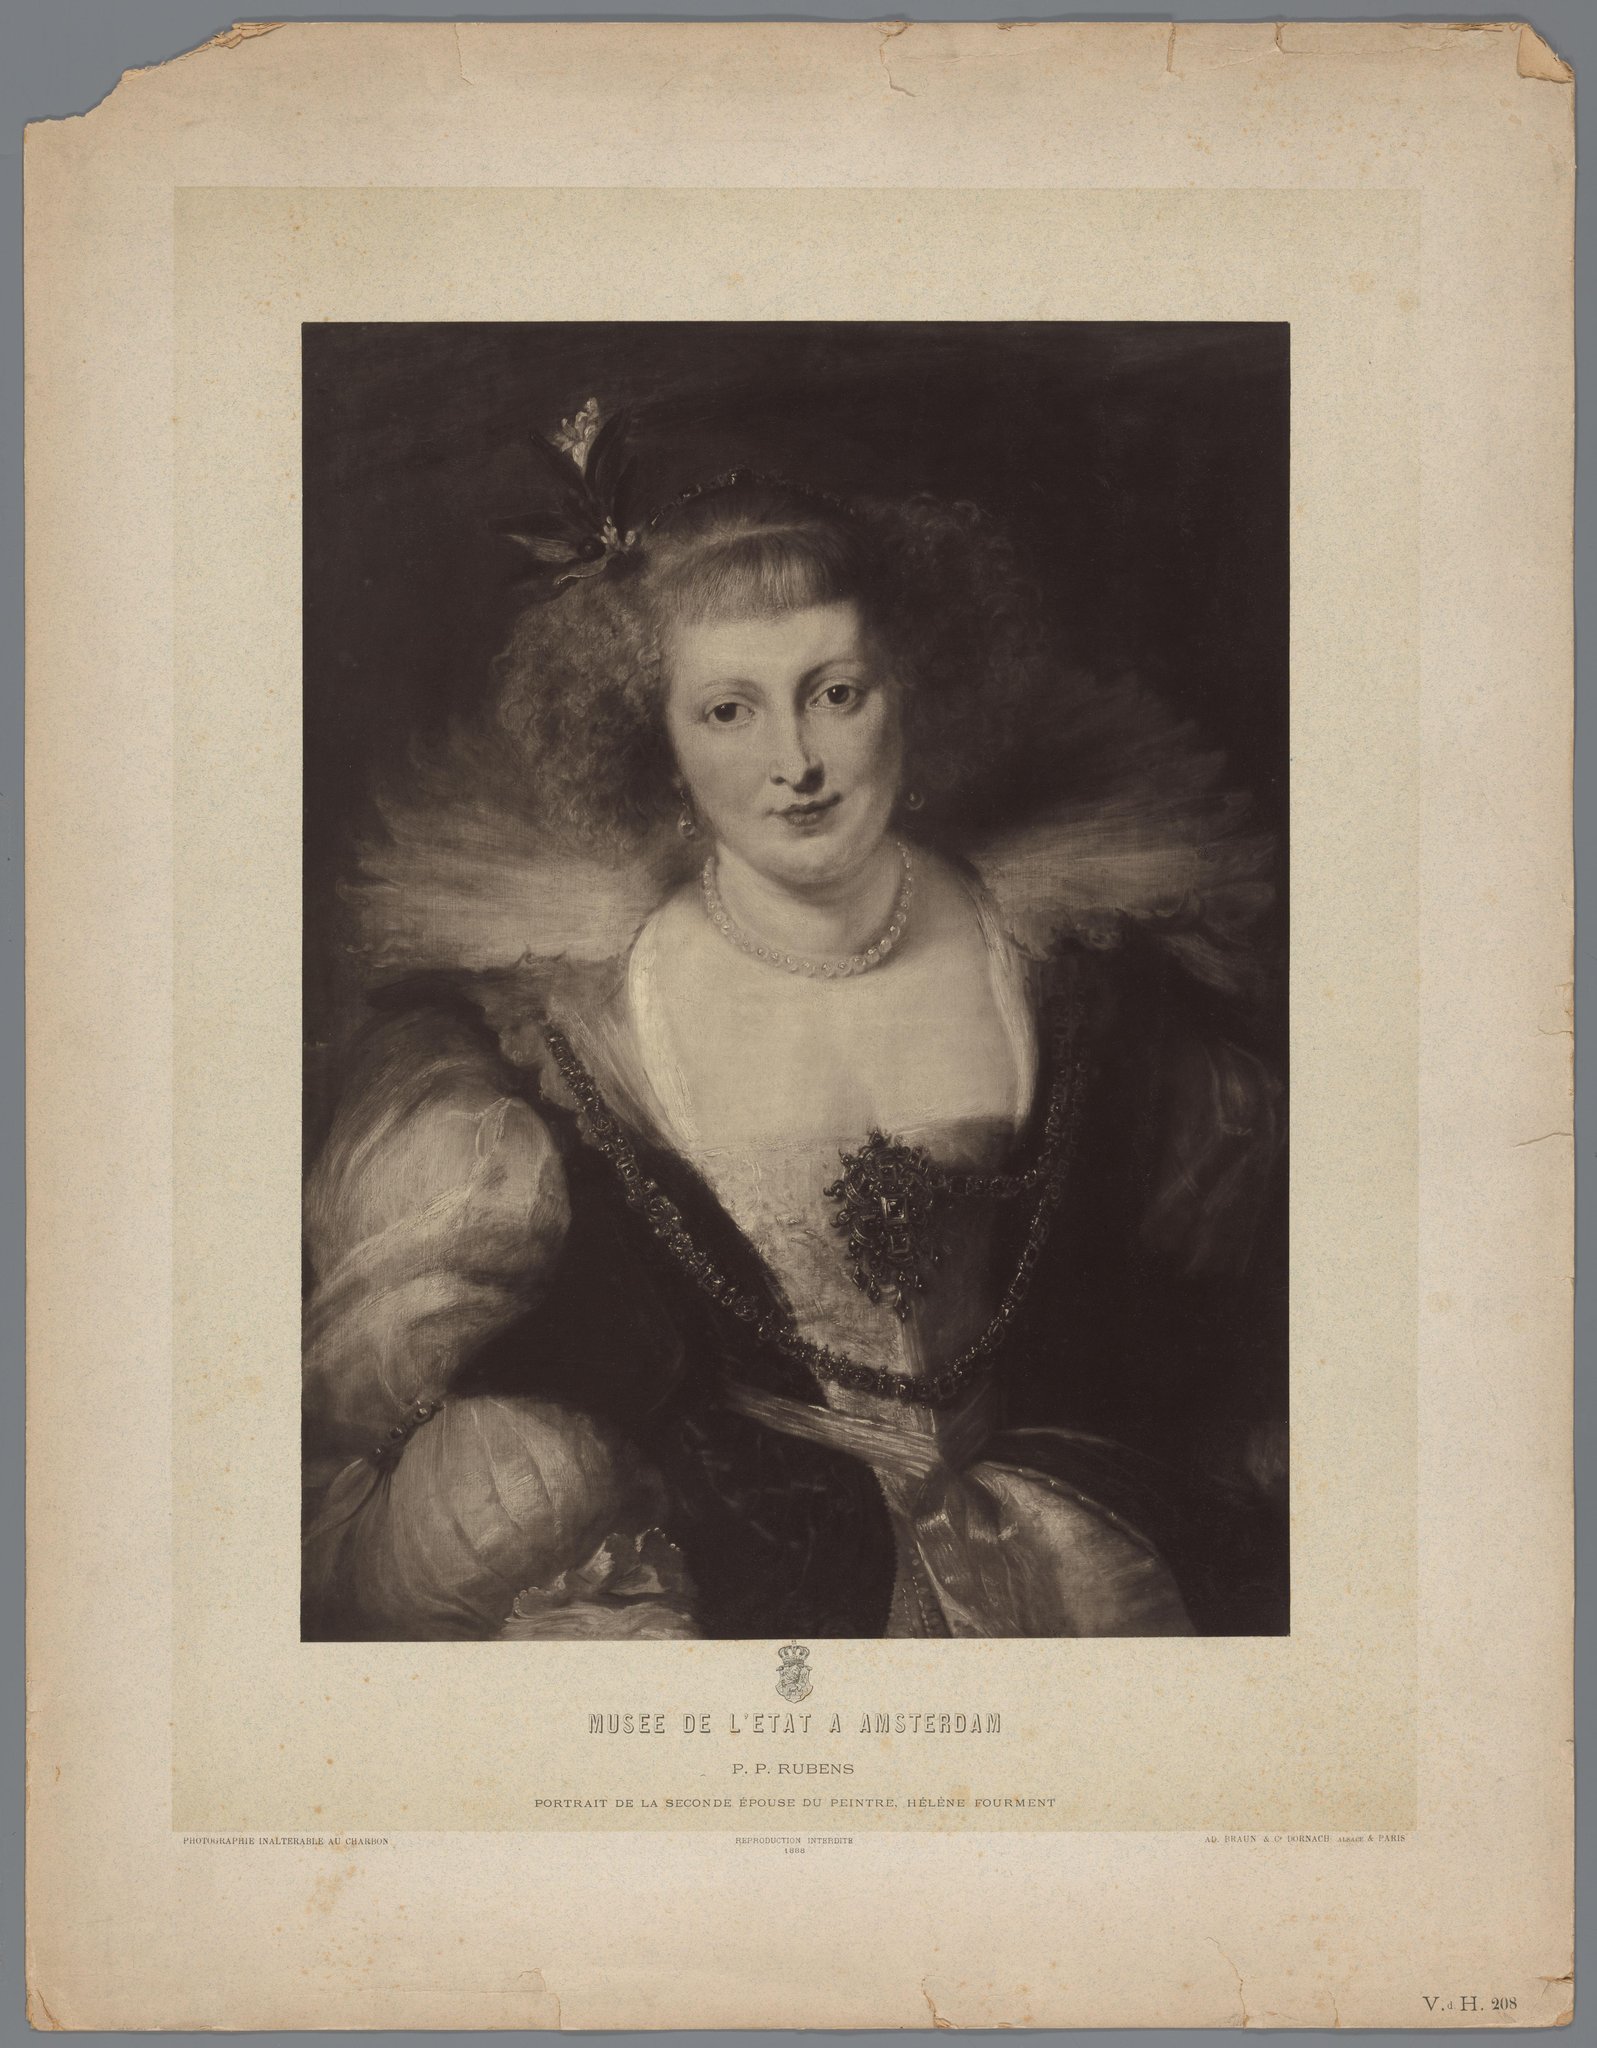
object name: photograph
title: Fotoreproductie van een schilderij van Perter Paul Rubens, 'Helena Fourment, tweede echtgenote van de schilder' (coll. Rijksmuseum)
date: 1888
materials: cardboard, paper, photographic support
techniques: carbon print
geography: france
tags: hélène fourment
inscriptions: signature and date: ‘Rechtsonder foto: Cliché ***’